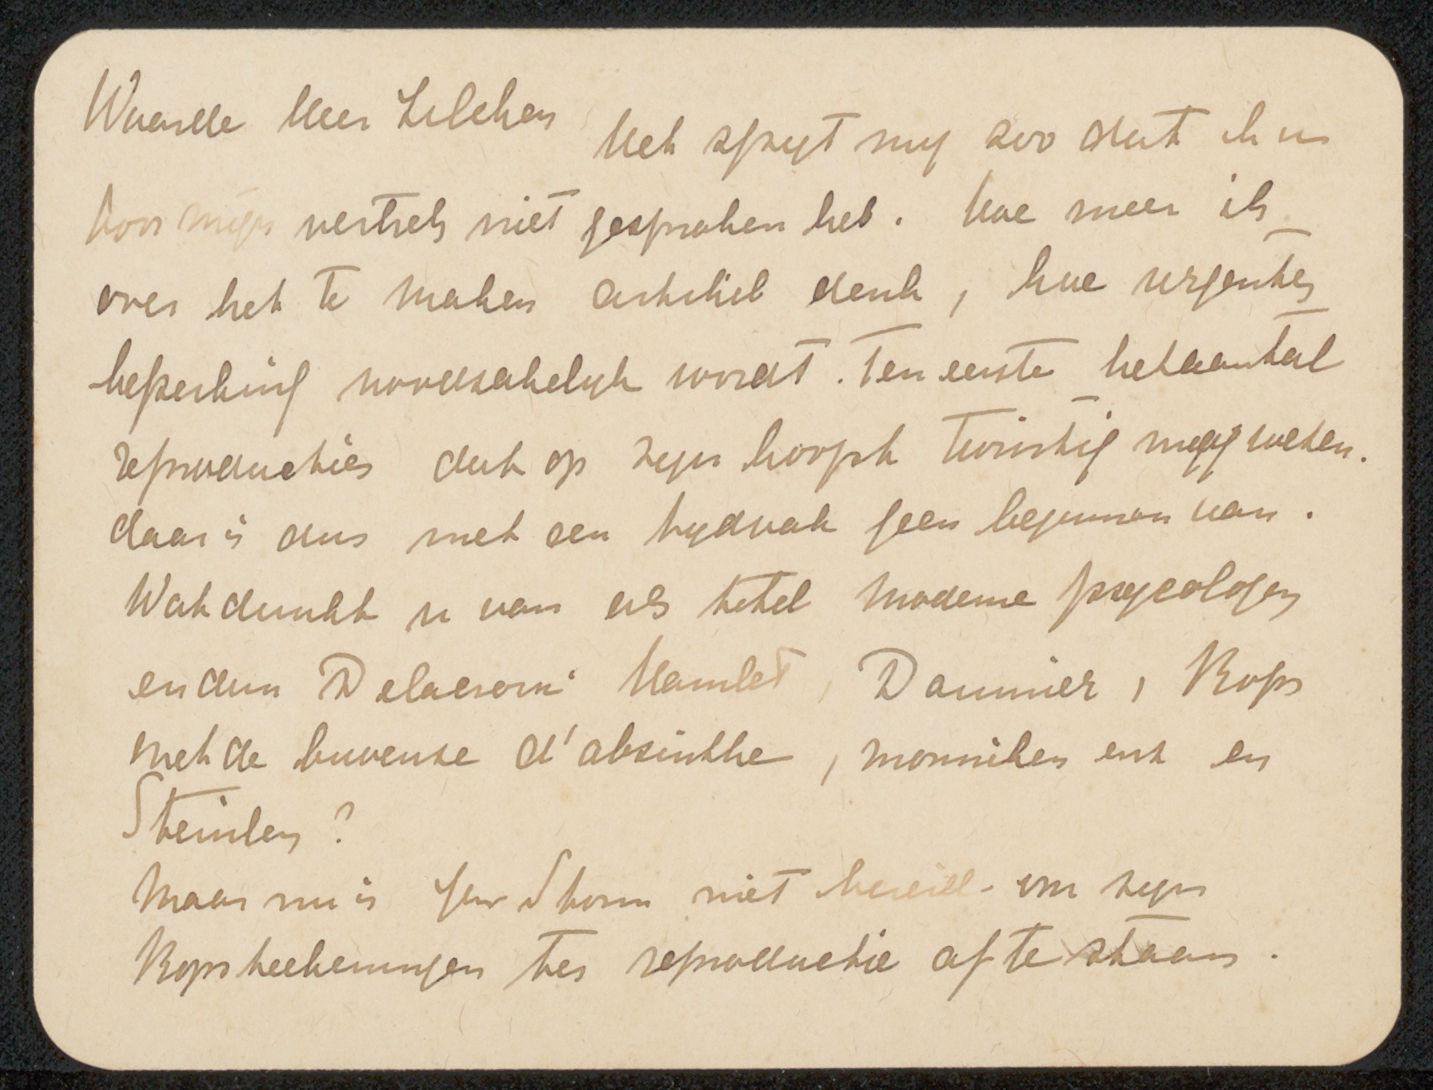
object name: letter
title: Brief aan Philip Zilcken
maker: grada hermina marius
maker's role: painter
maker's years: 1854-1919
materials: cardboard, ink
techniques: pen, writing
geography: katwijk aan zee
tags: paris, eugène delacroix, print maker, draughtsman, vincent van gogh, sculptor, théophile alexandre steinlen, honoré daumier, félicien rops, philip zilcken, the graphic arts, printed matter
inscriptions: collector's mark: ‘RPK’